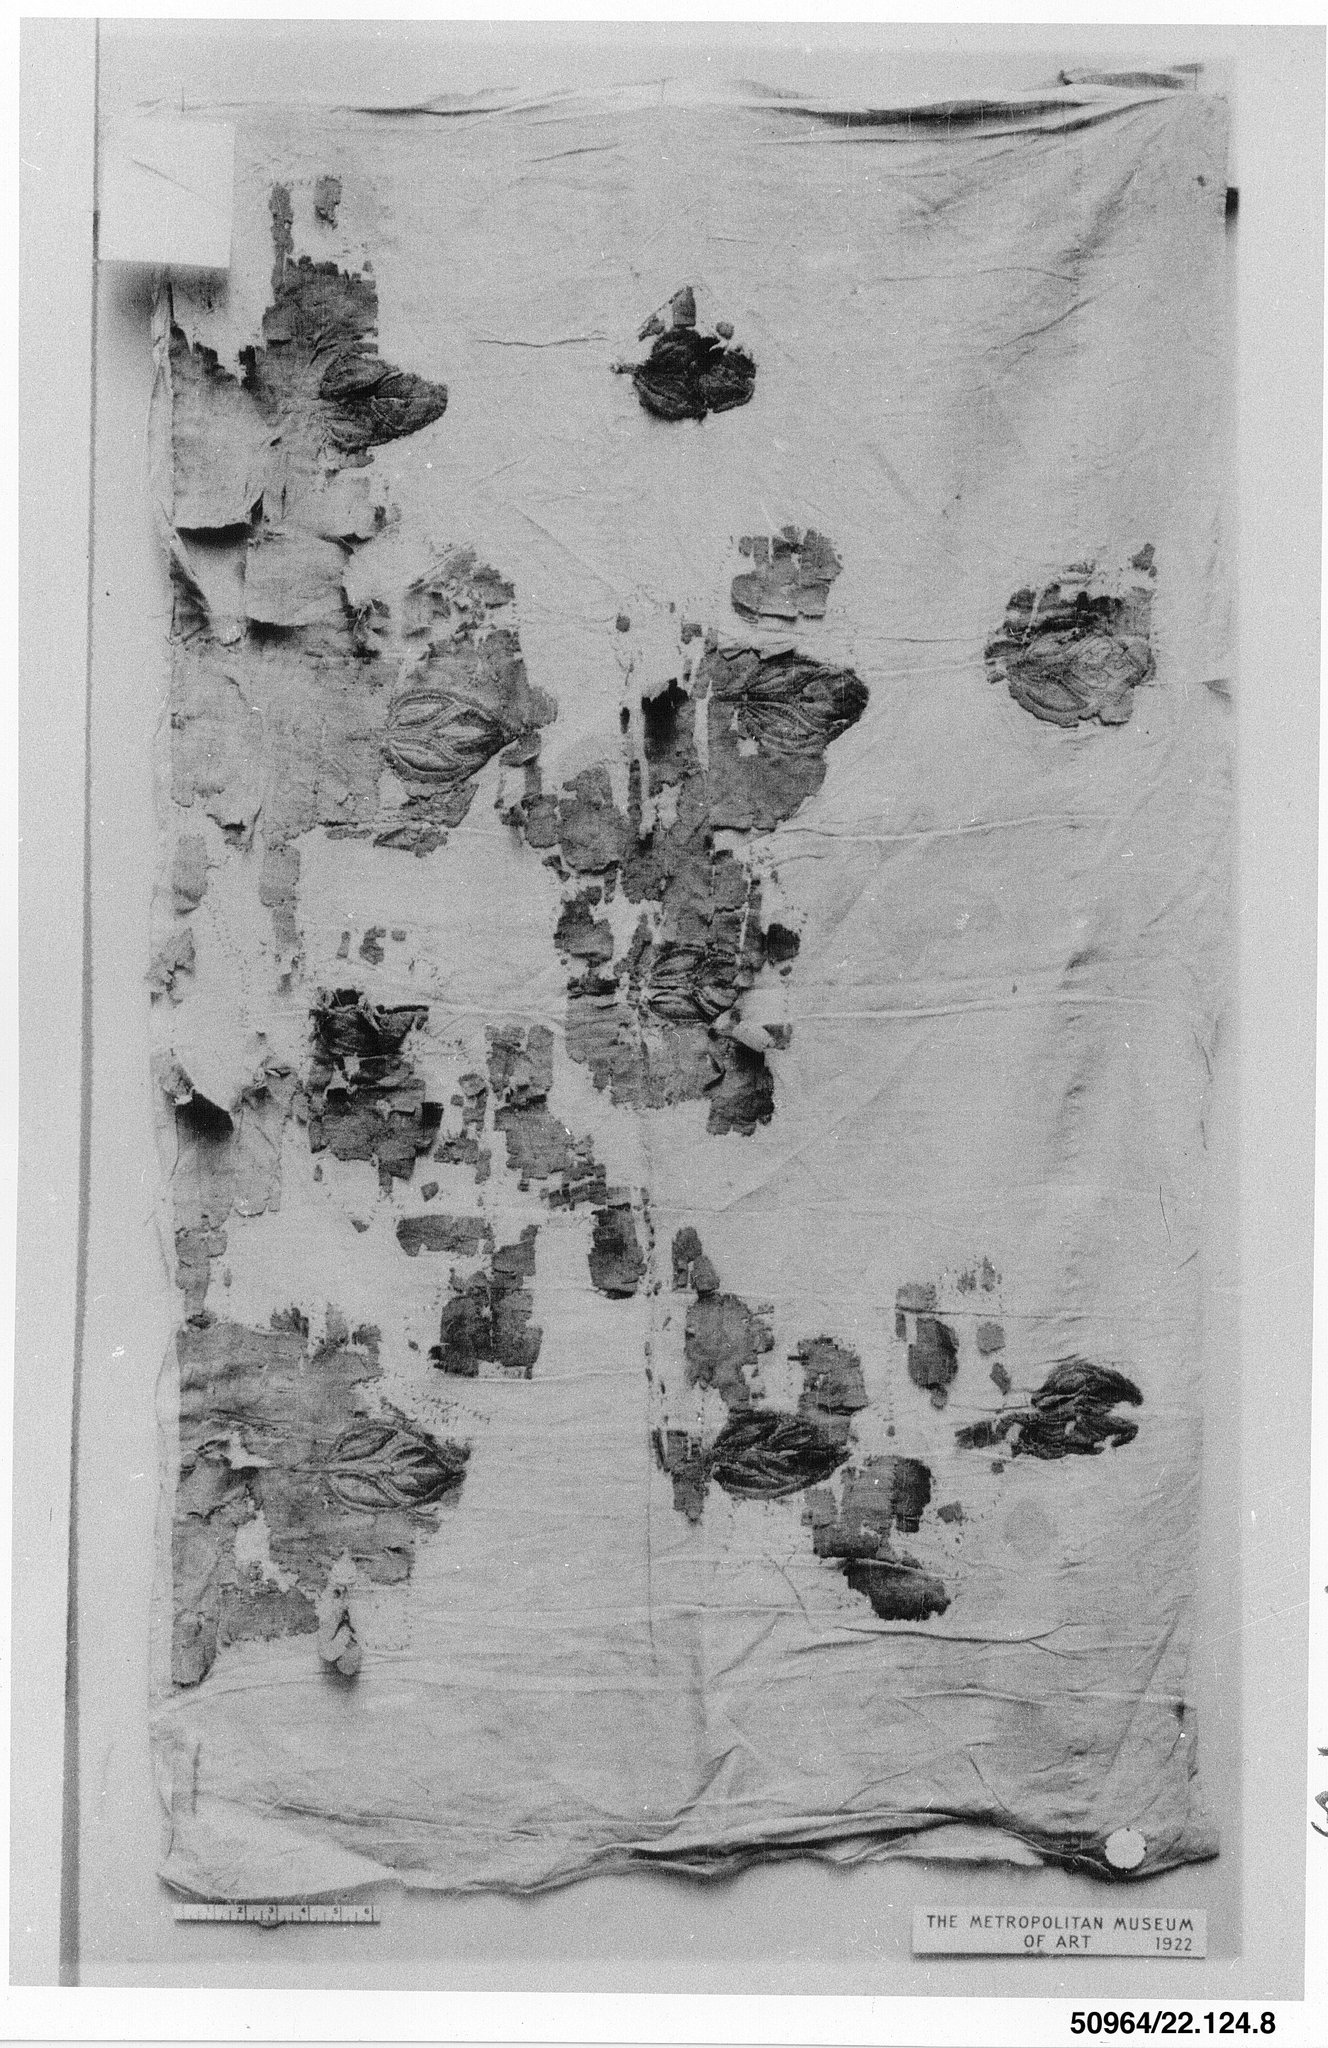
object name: fragment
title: Textile Fragment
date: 301-600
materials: linen, wool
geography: egypt